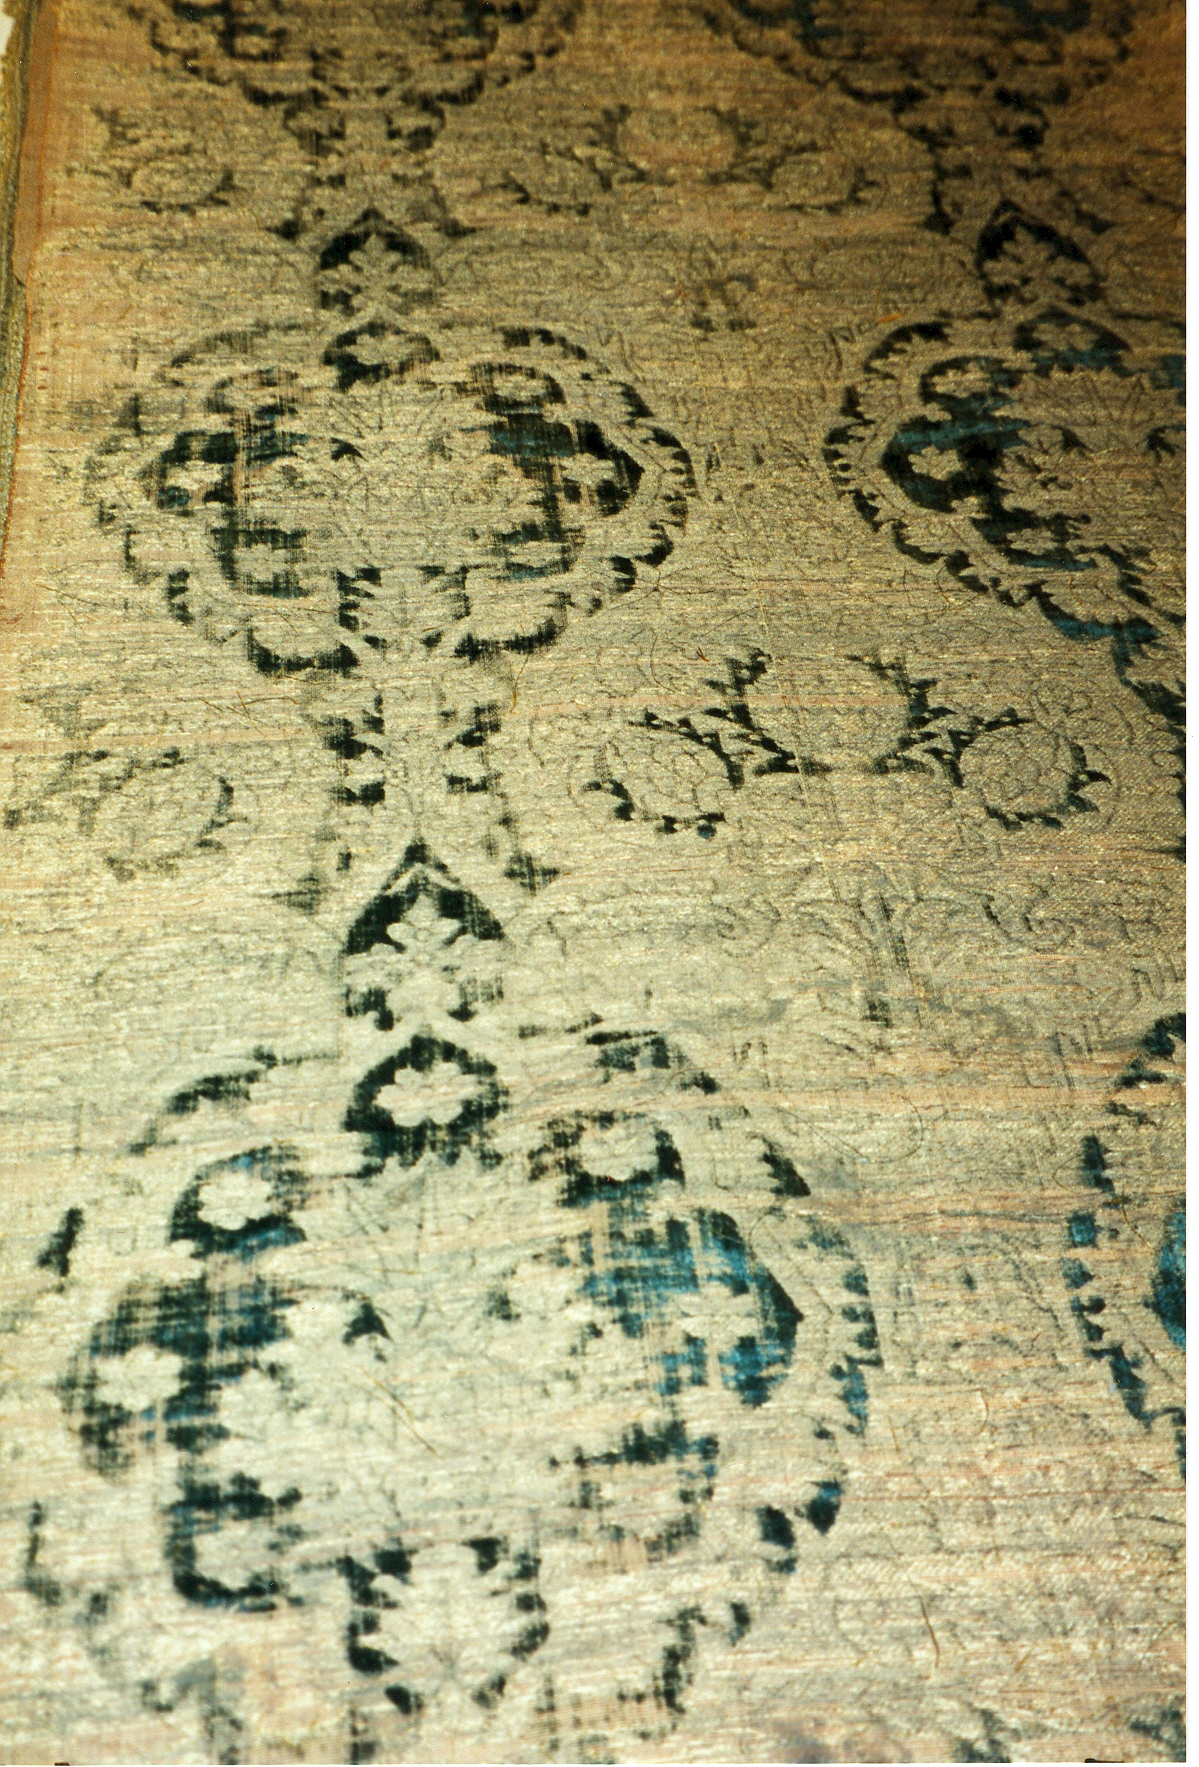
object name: textile panel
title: Panel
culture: italian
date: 1401-1500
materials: silk